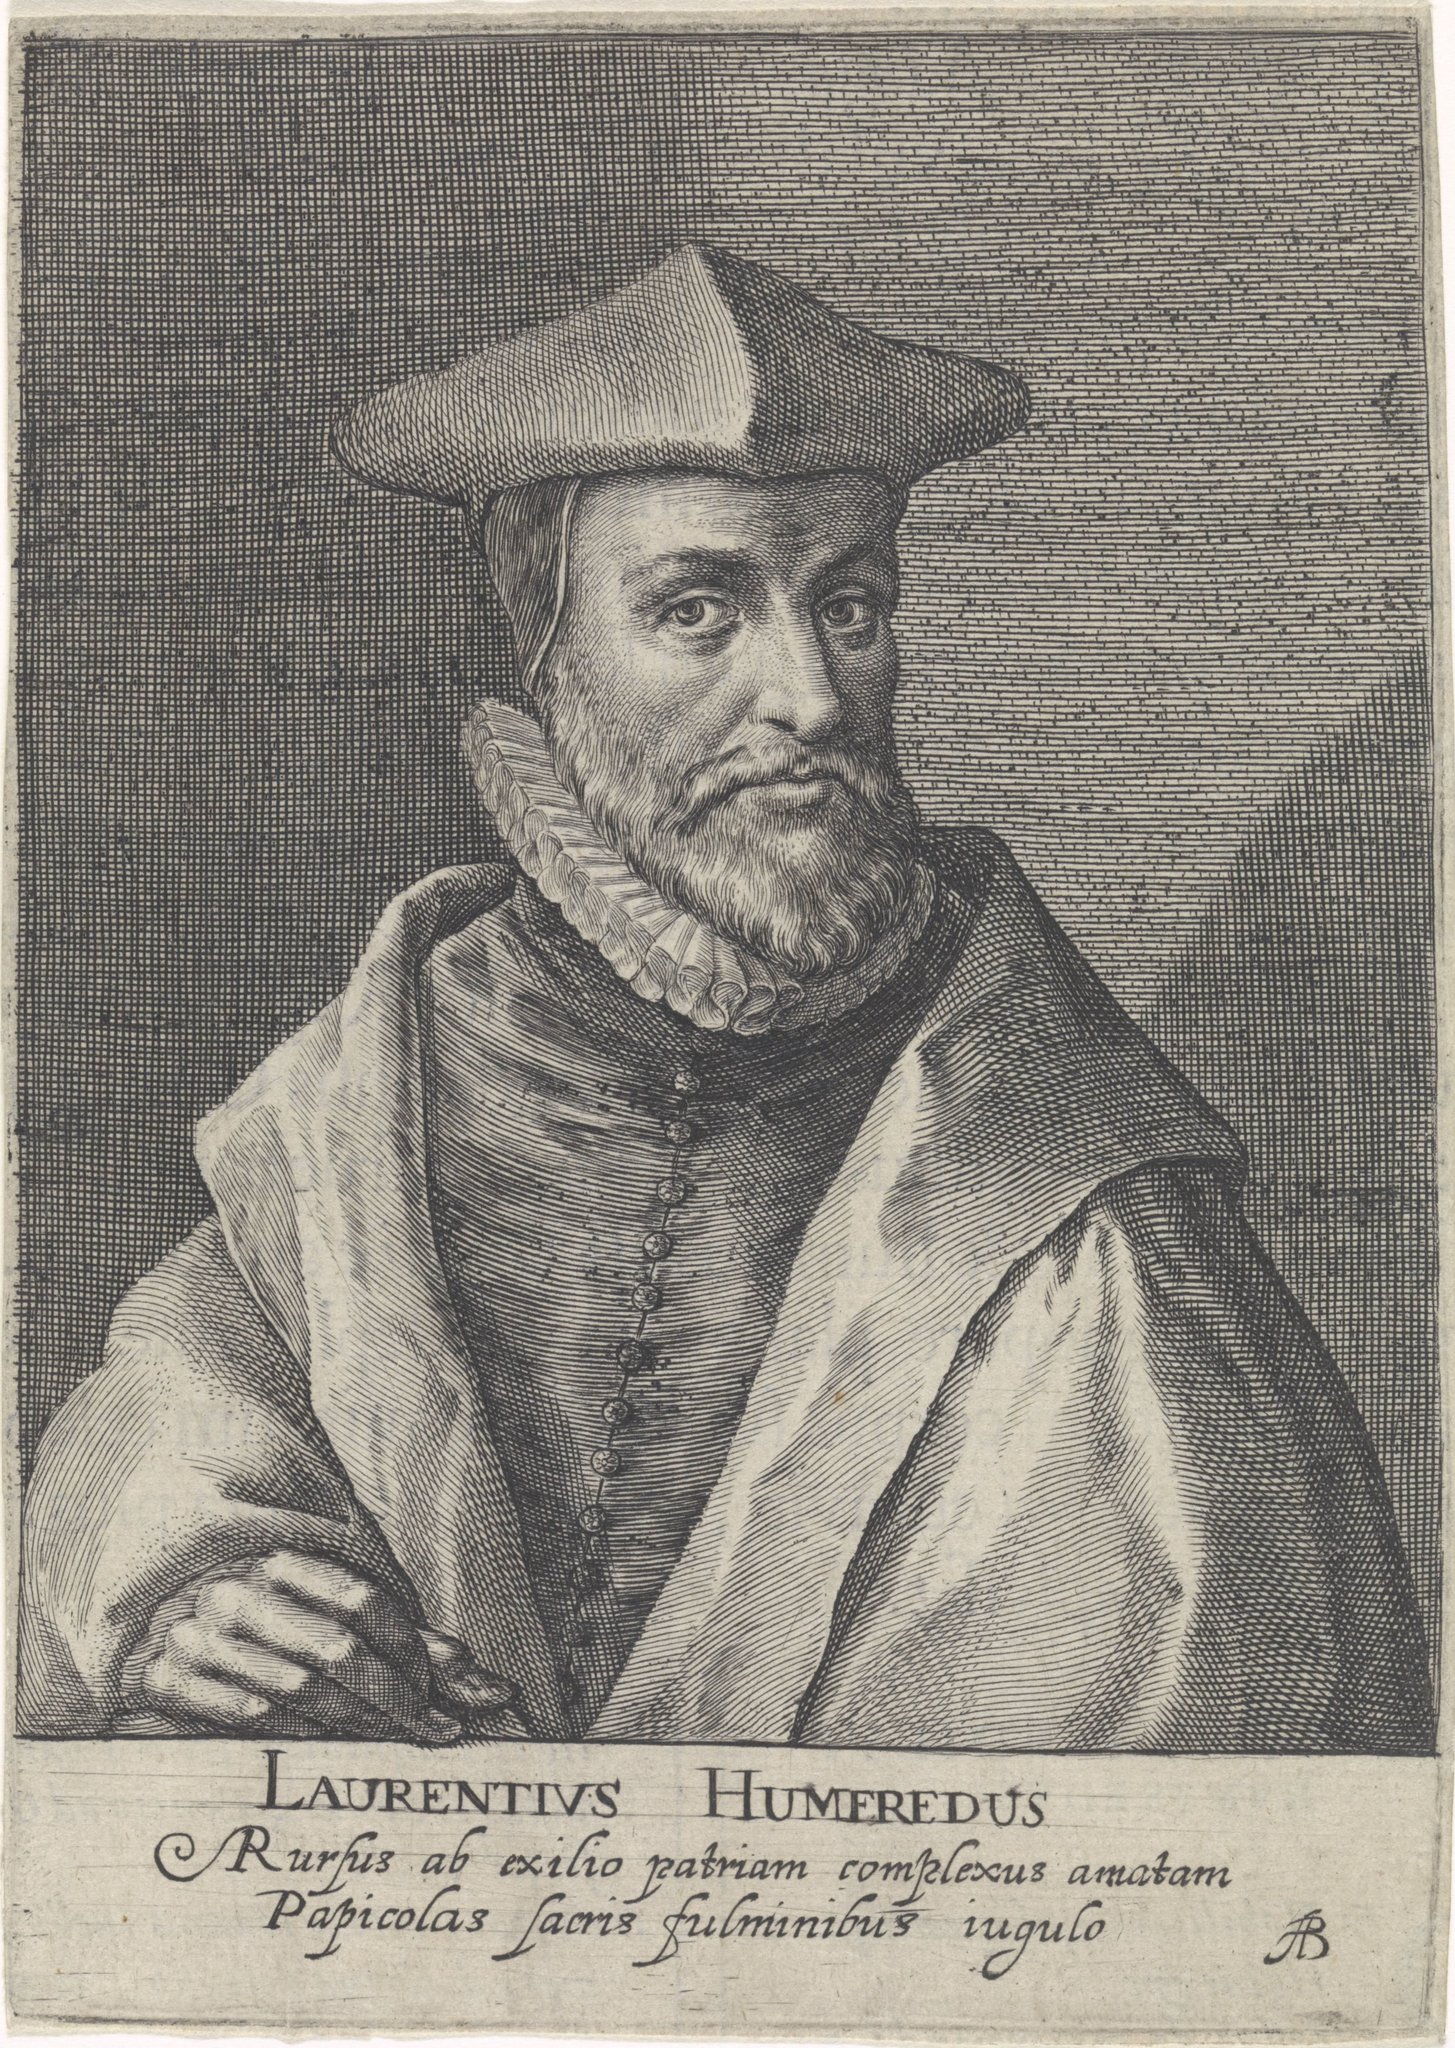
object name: book illustration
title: Portret van Lawrence Humphrey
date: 1620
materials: paper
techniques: engraving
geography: utrecht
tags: theoloog, lawrence humphrey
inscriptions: collector's mark: Lugt 2228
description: Portret van de Engelse theoloog Lawrence Humphrey. In de marge de naam van de geportretteerde en een tweeregelig lofdicht in het Latijn.